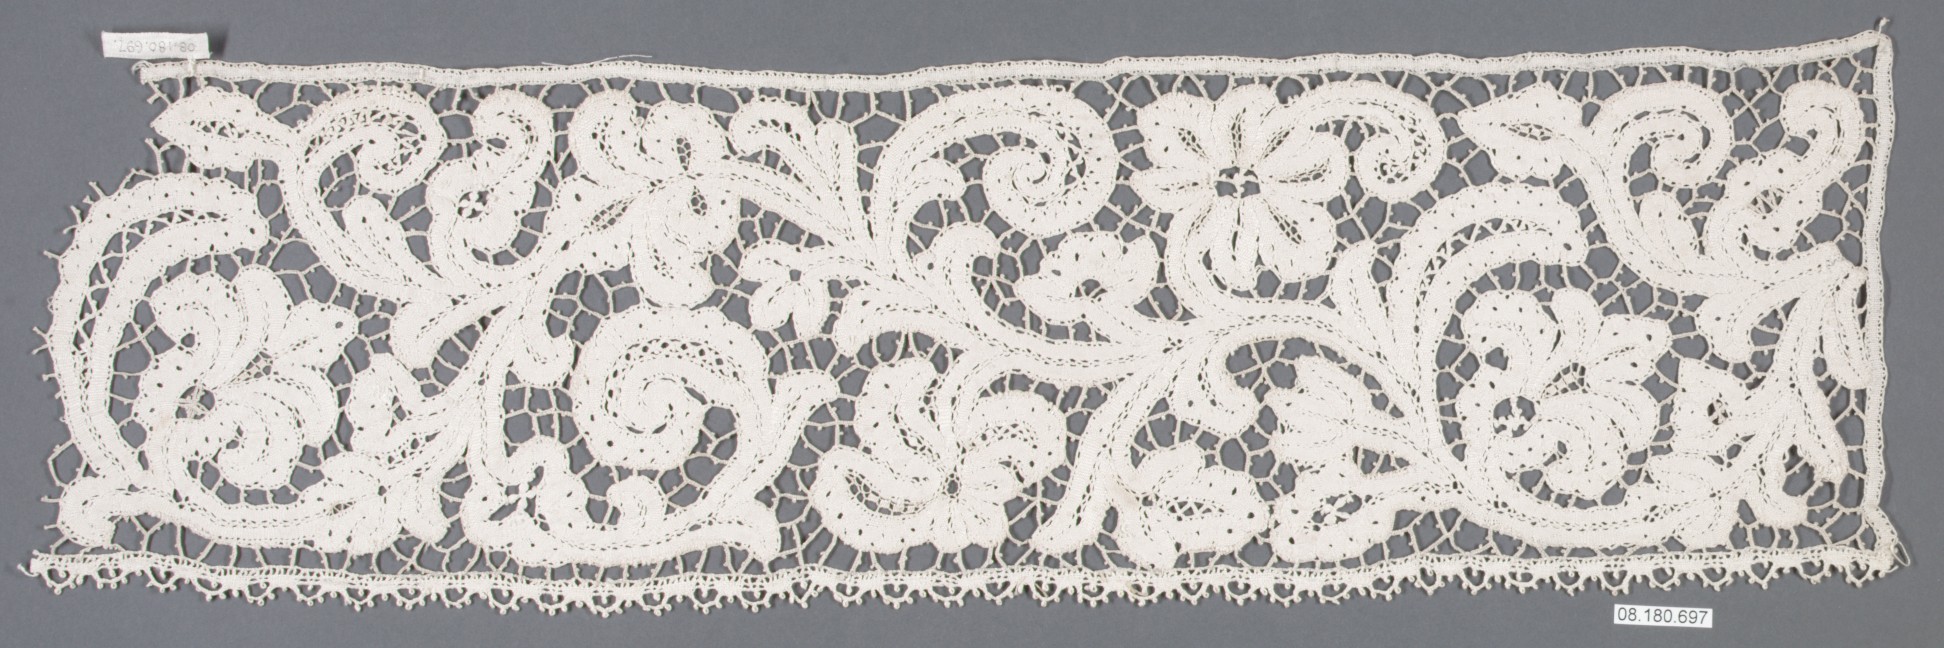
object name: fragment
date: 1701-1800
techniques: lace